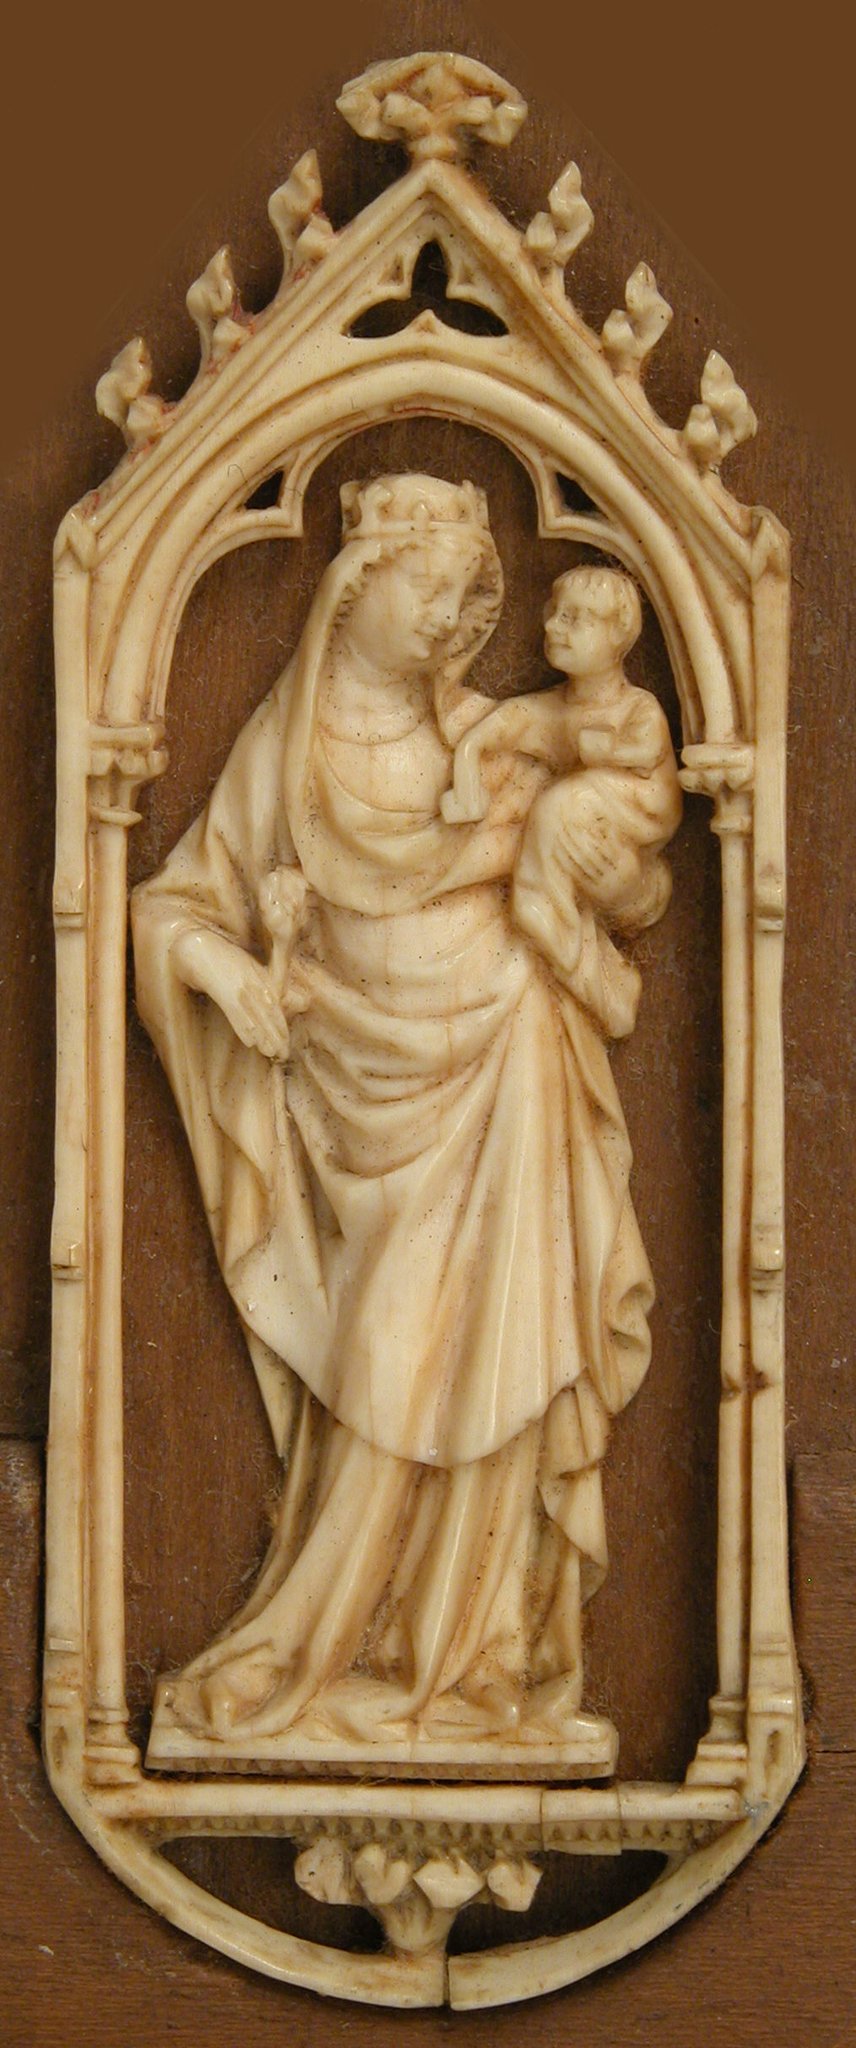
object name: panel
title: Panel with Virgin and Child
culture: french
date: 1301-1400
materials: ivory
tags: christ,virgin mary